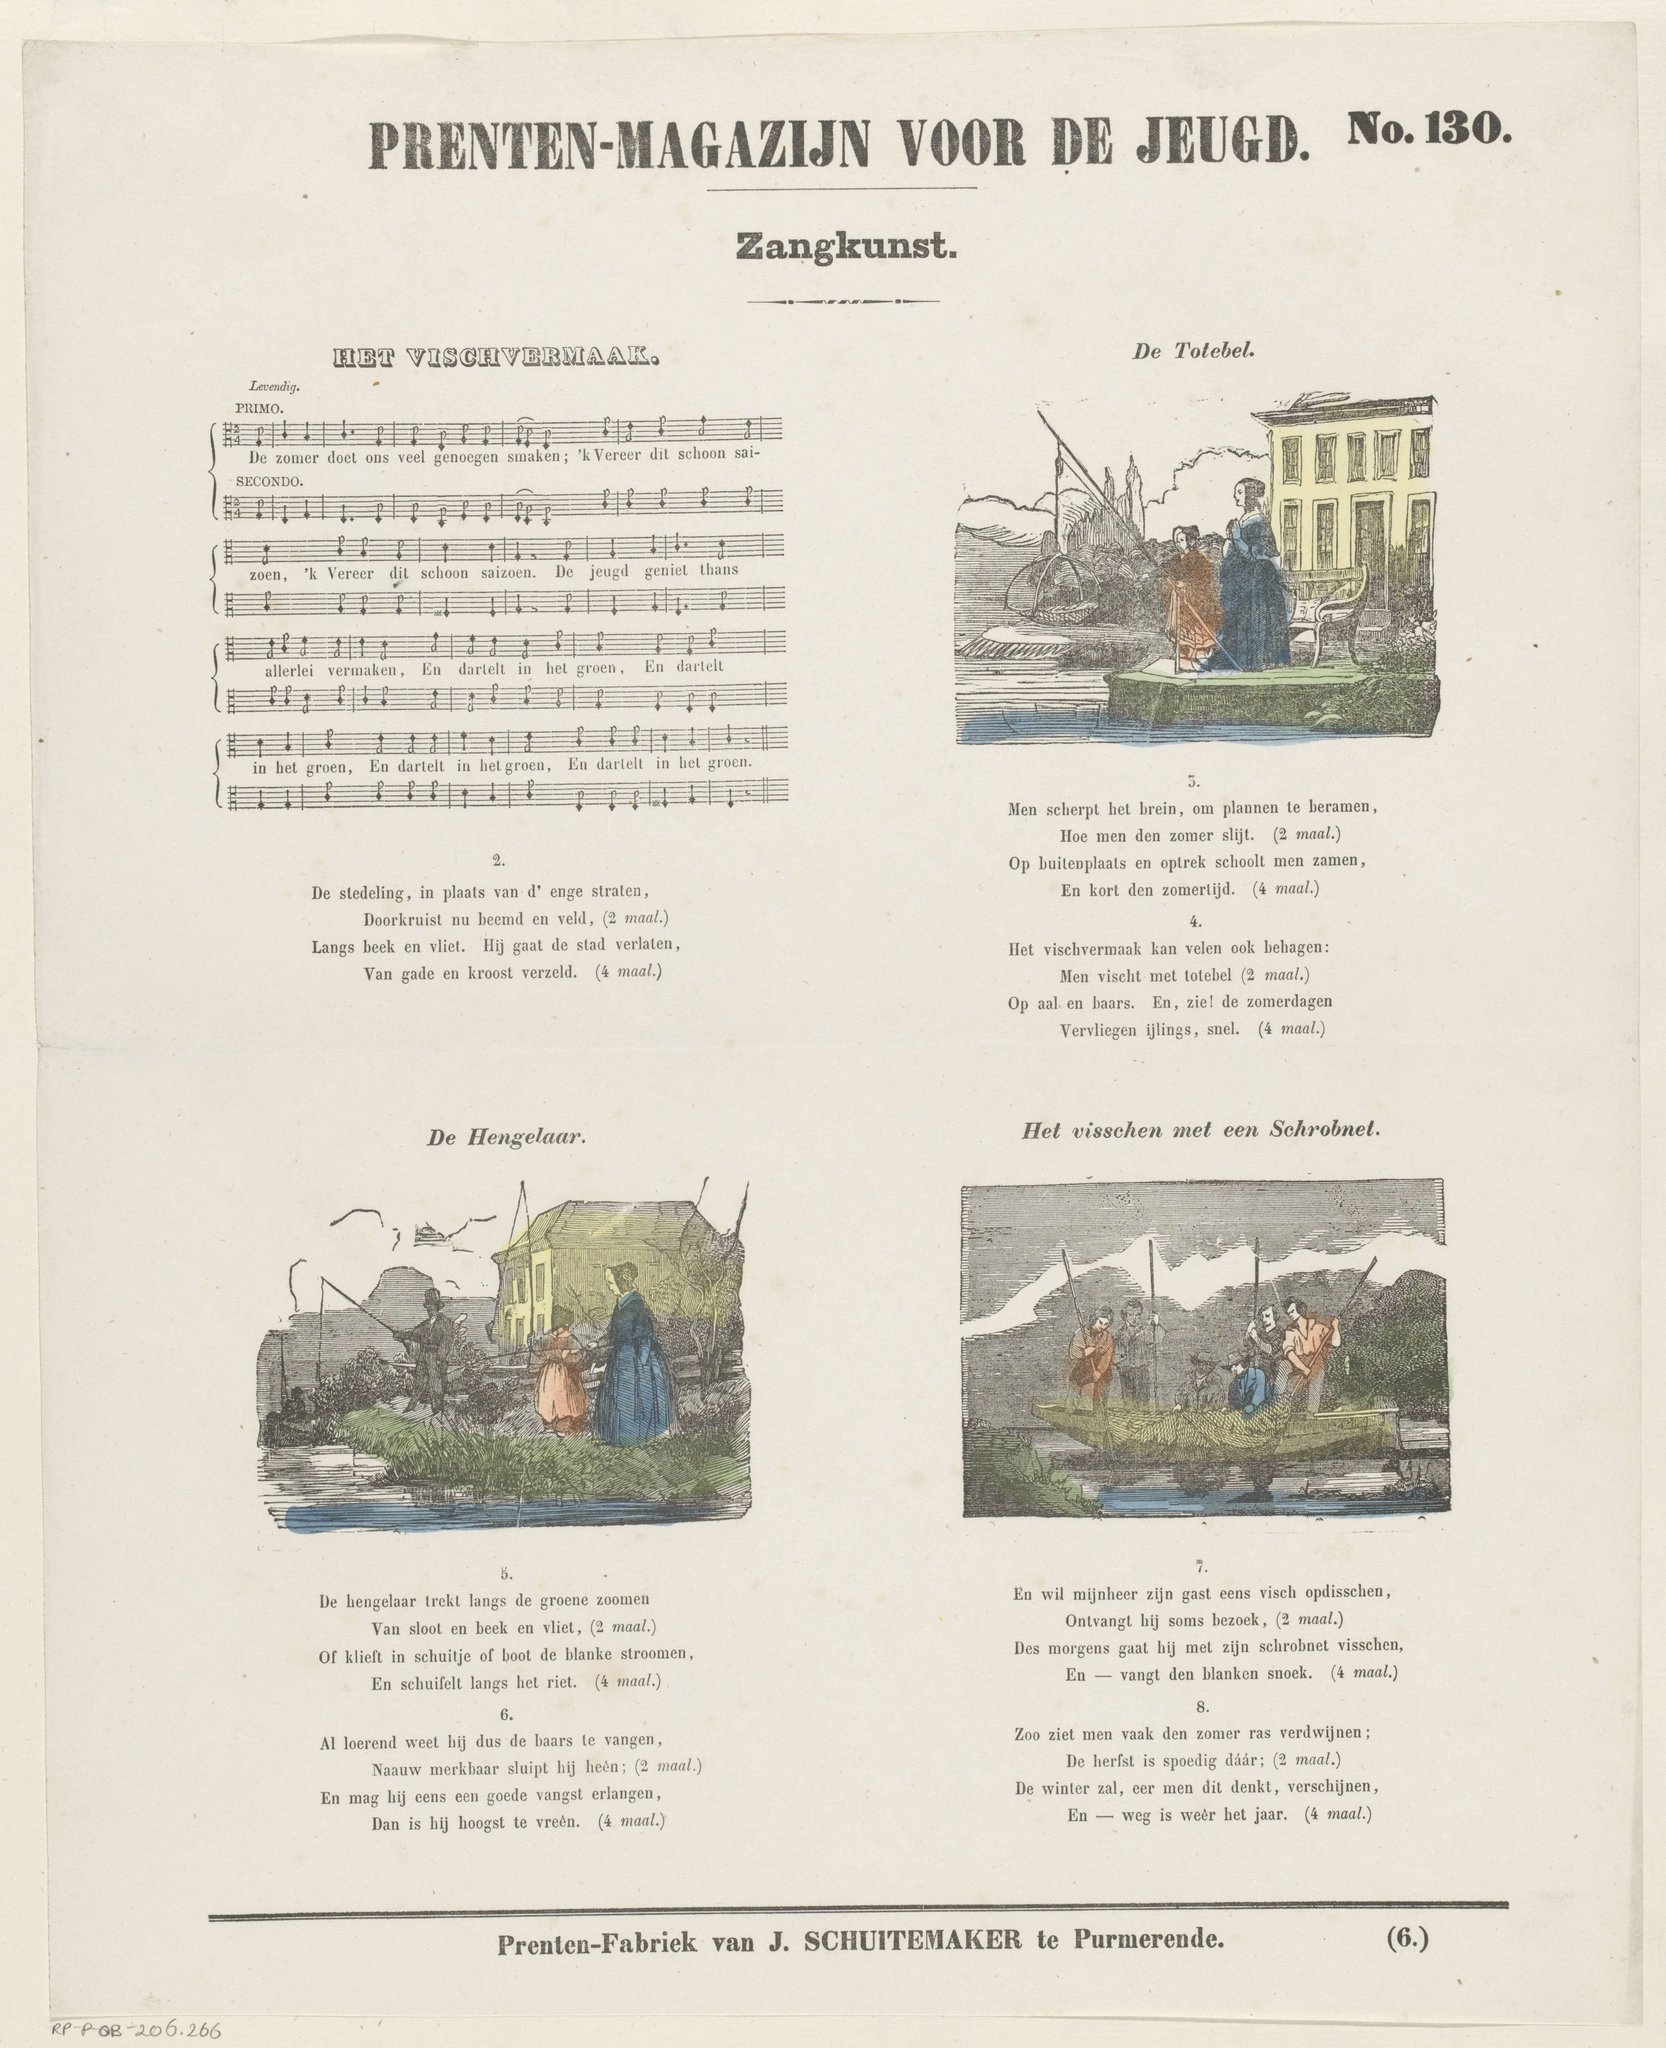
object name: popular print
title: Vissen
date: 1850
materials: paper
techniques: colour, letterpress printing, engraving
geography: netherlands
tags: fishing (sports)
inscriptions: collector's mark: Lugt 2760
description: Na voltooiing van de acht jaargangen van de reeks 'Prenten-magazijn voor de jeugd' in 1850 heeft Jan Schuitemaker al deze prenten heruitgegeven en omgenummerd als nr. 1 t/m 192. De oorspronkelijke jaargang wordt telkens nog vermeld rechtsonder op de prent. Binnen de jaargangen zijn prenten van hetzelfde thema in clusters van vier achter elkaar gezet.